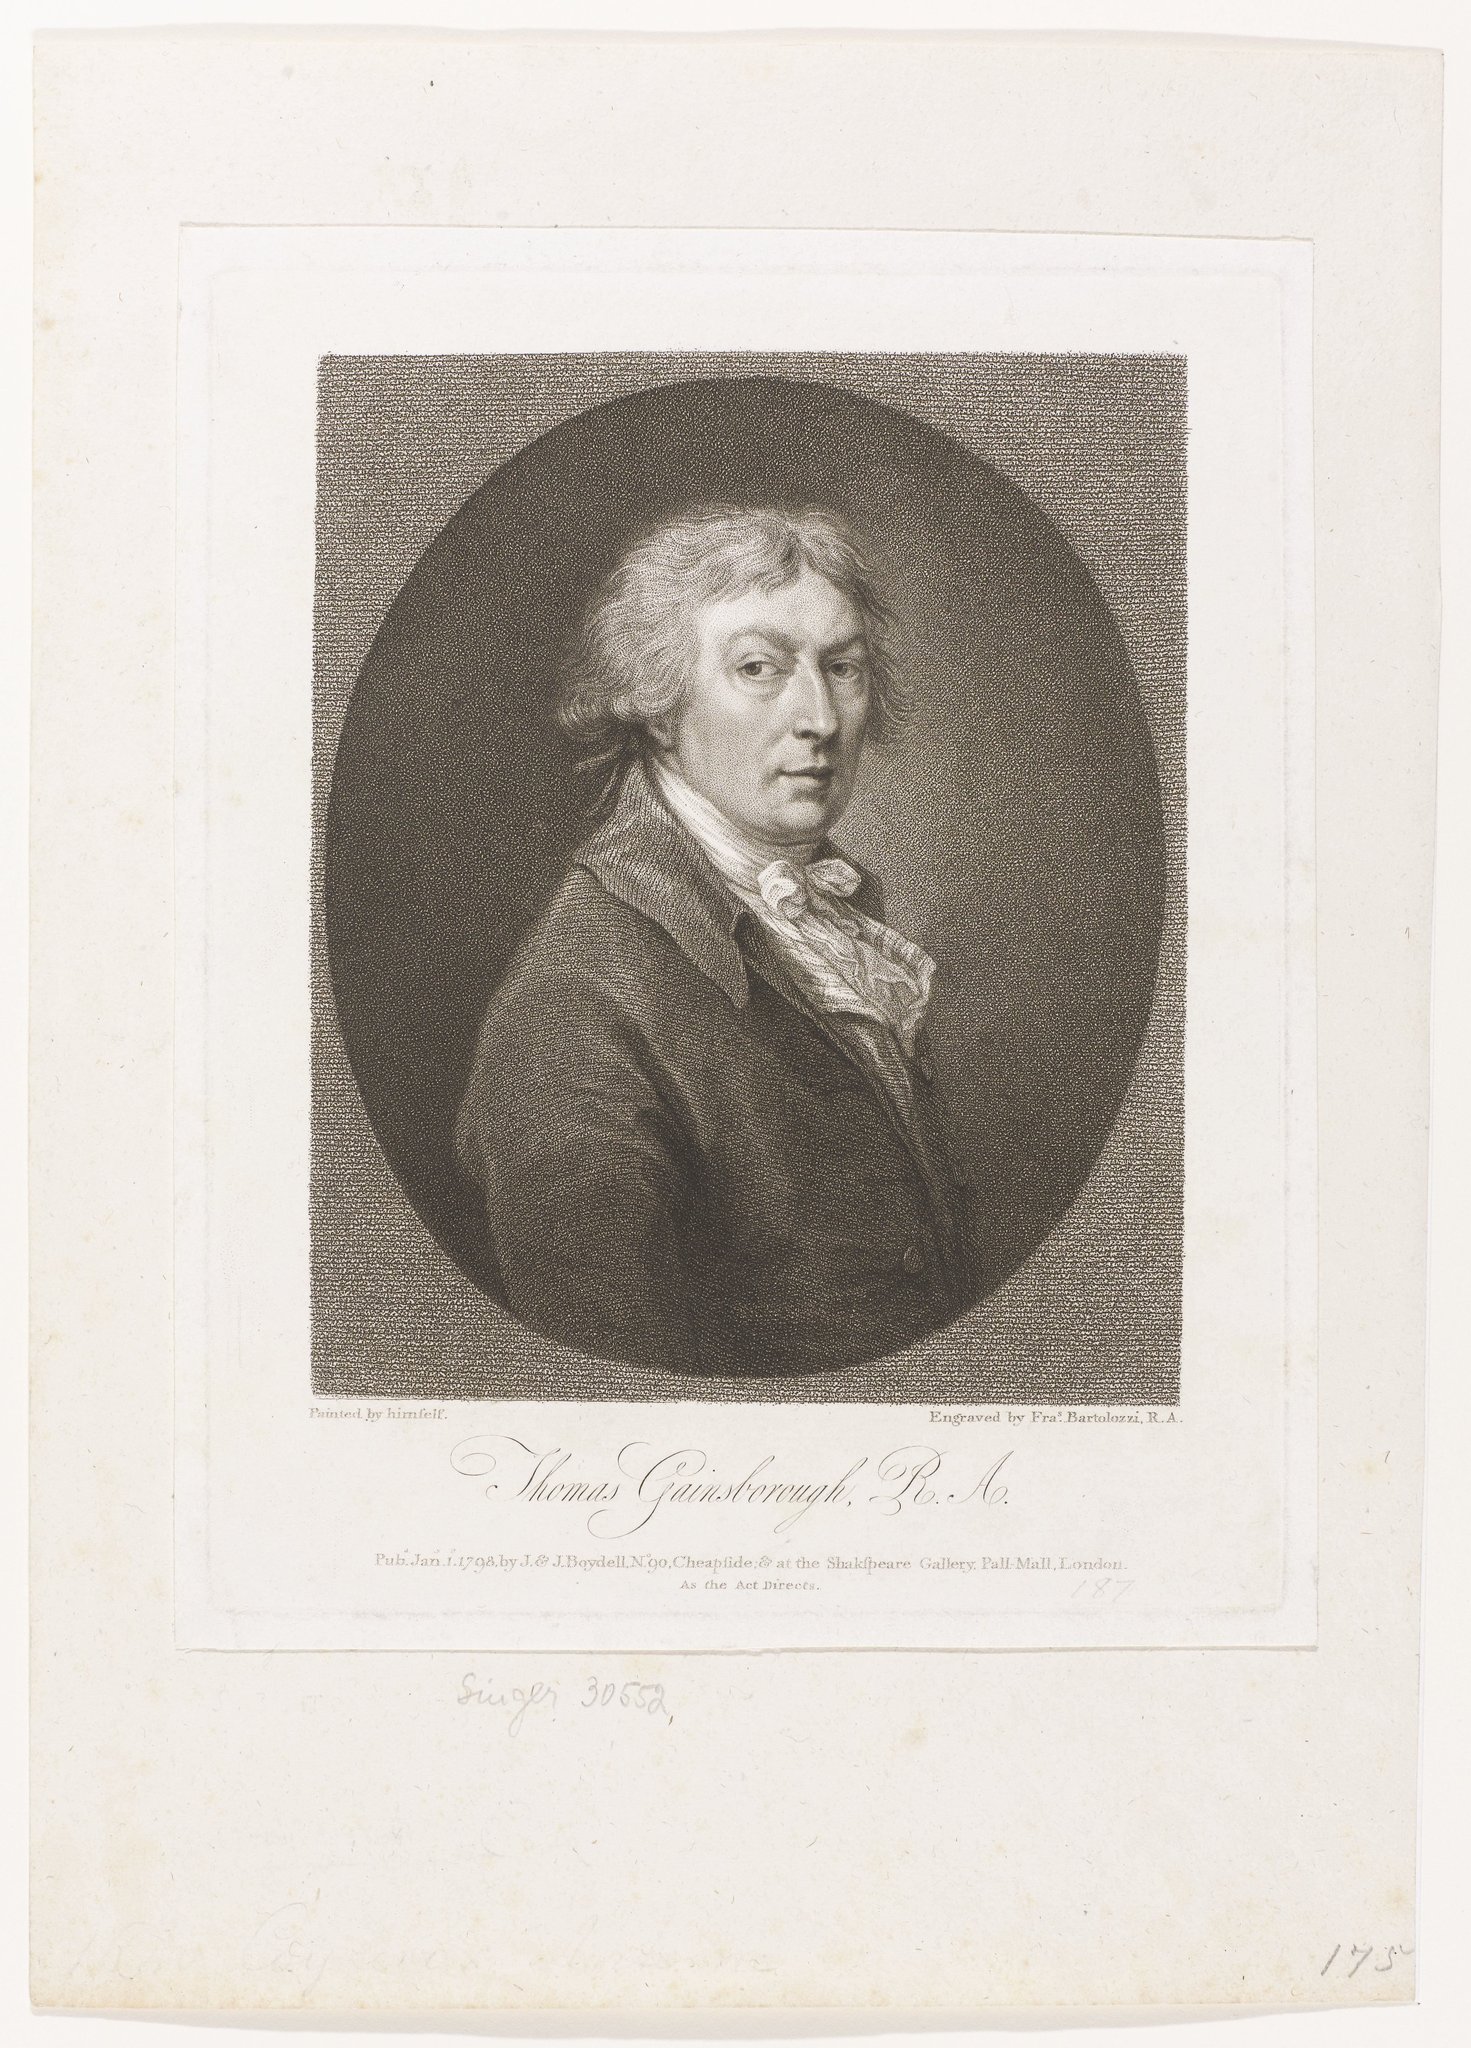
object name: print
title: Portret van Thomas Gainsborough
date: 1787-1815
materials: paper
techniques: etching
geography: london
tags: london, print maker, draughtsman, thomas gainsborough, historical persons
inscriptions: collector's mark: Lugt 2228, collector's mark: Lugt 2760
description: Naar geschilderd zelfportret in de Royal Academy of Arts in Londen.